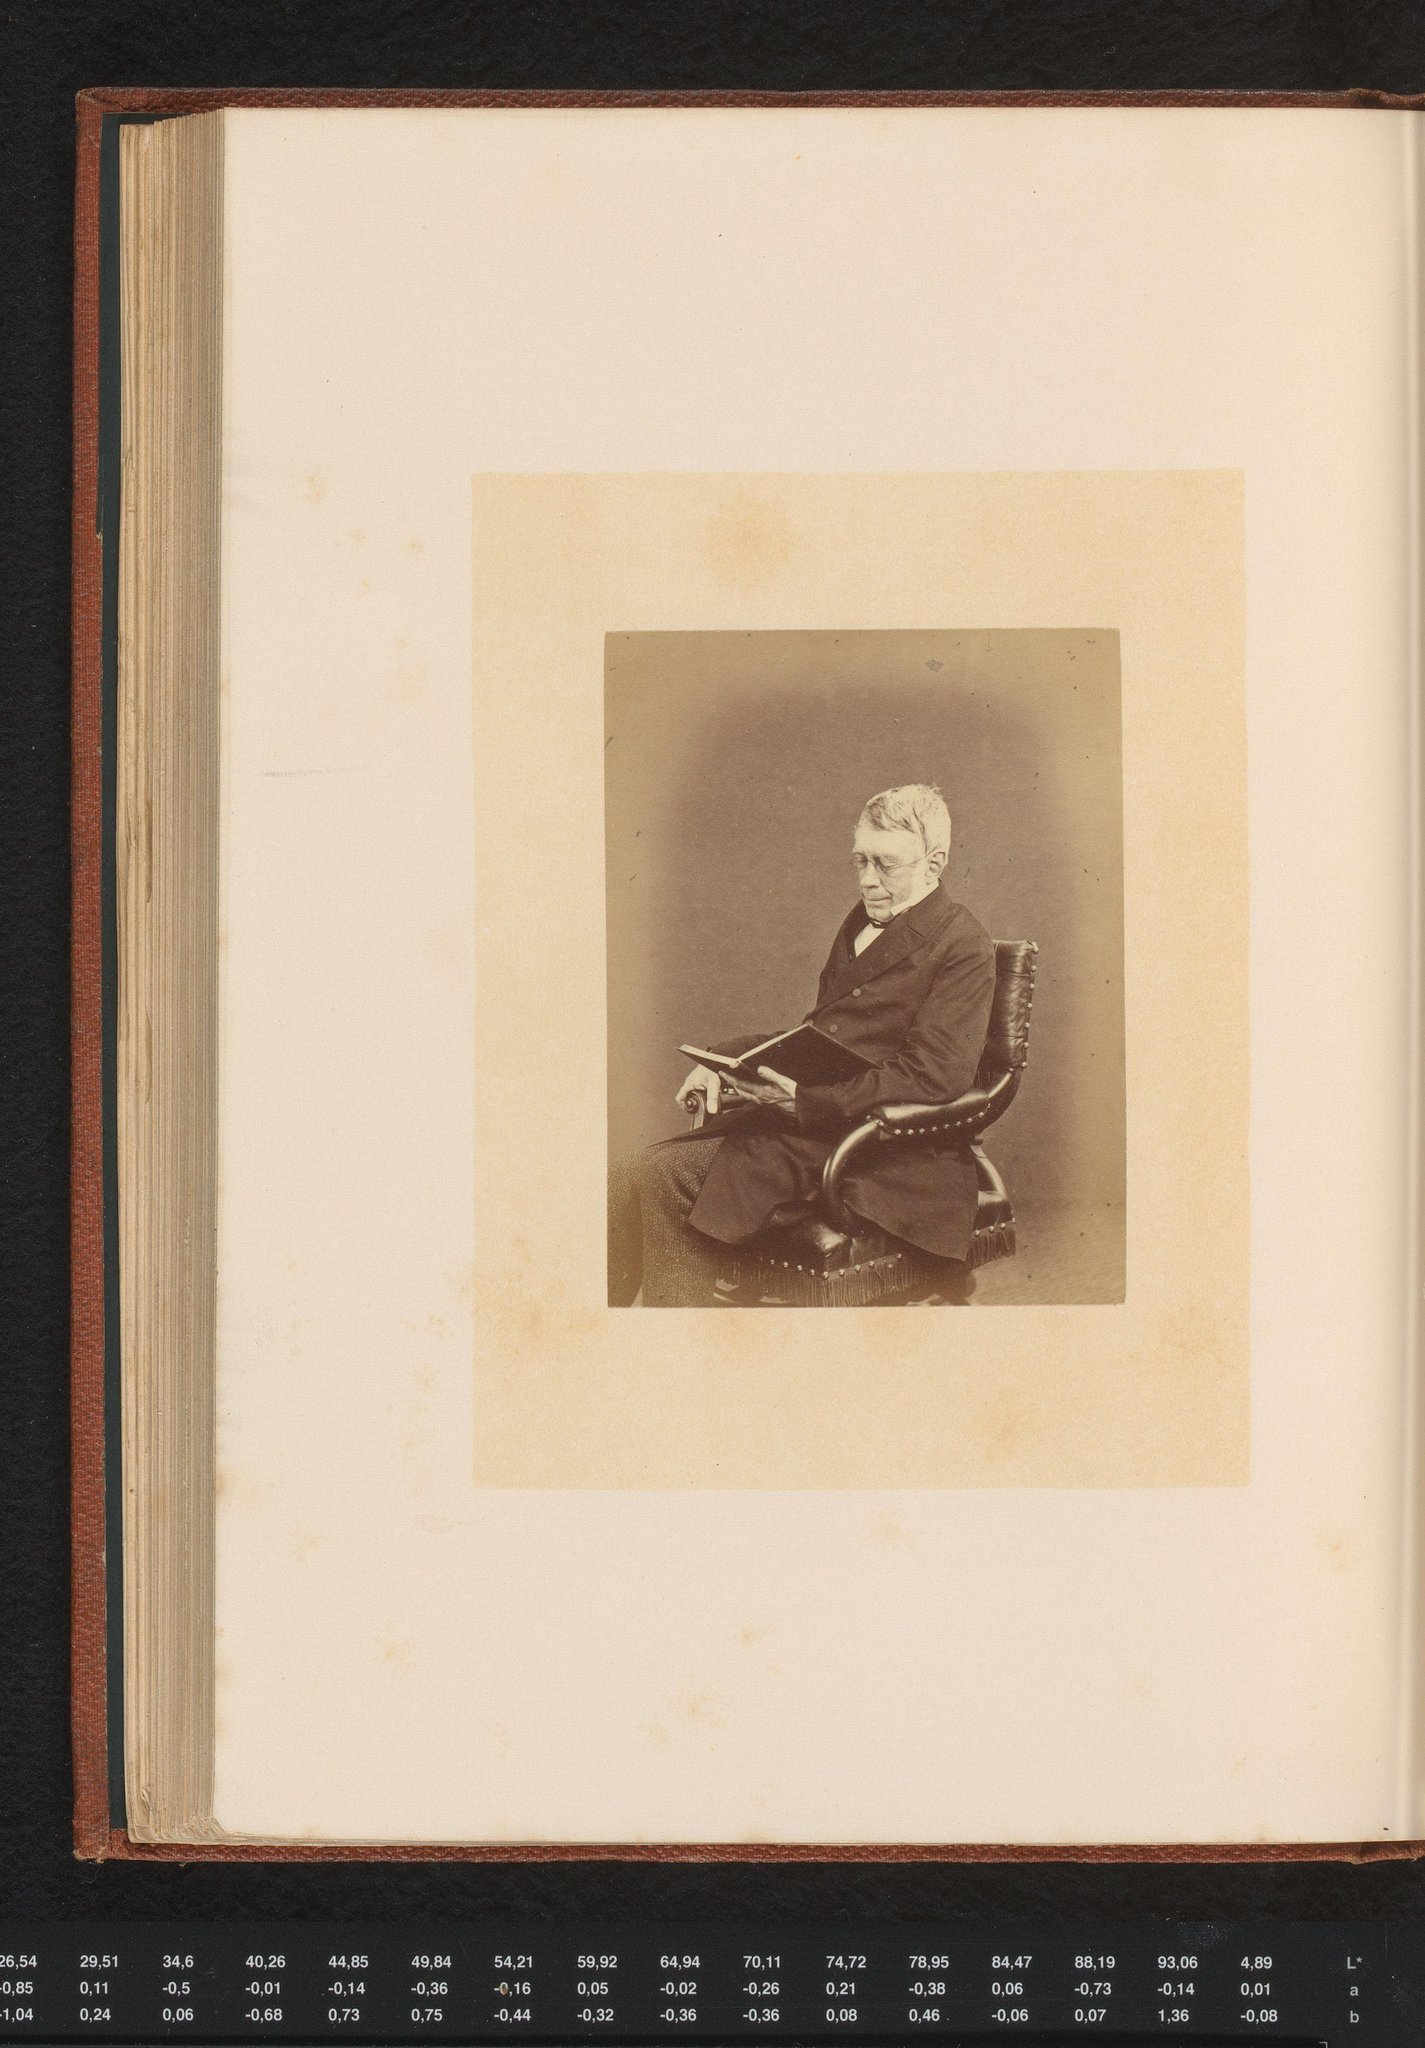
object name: photograph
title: Portret van de astronoom en wiskundige George Biddell Airy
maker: ernest edwards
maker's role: fotograaf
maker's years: 1837-1903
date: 1861-1866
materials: paper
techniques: albumen print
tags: astronomy (and cosmography) (+ portrait of scholar, scientist)